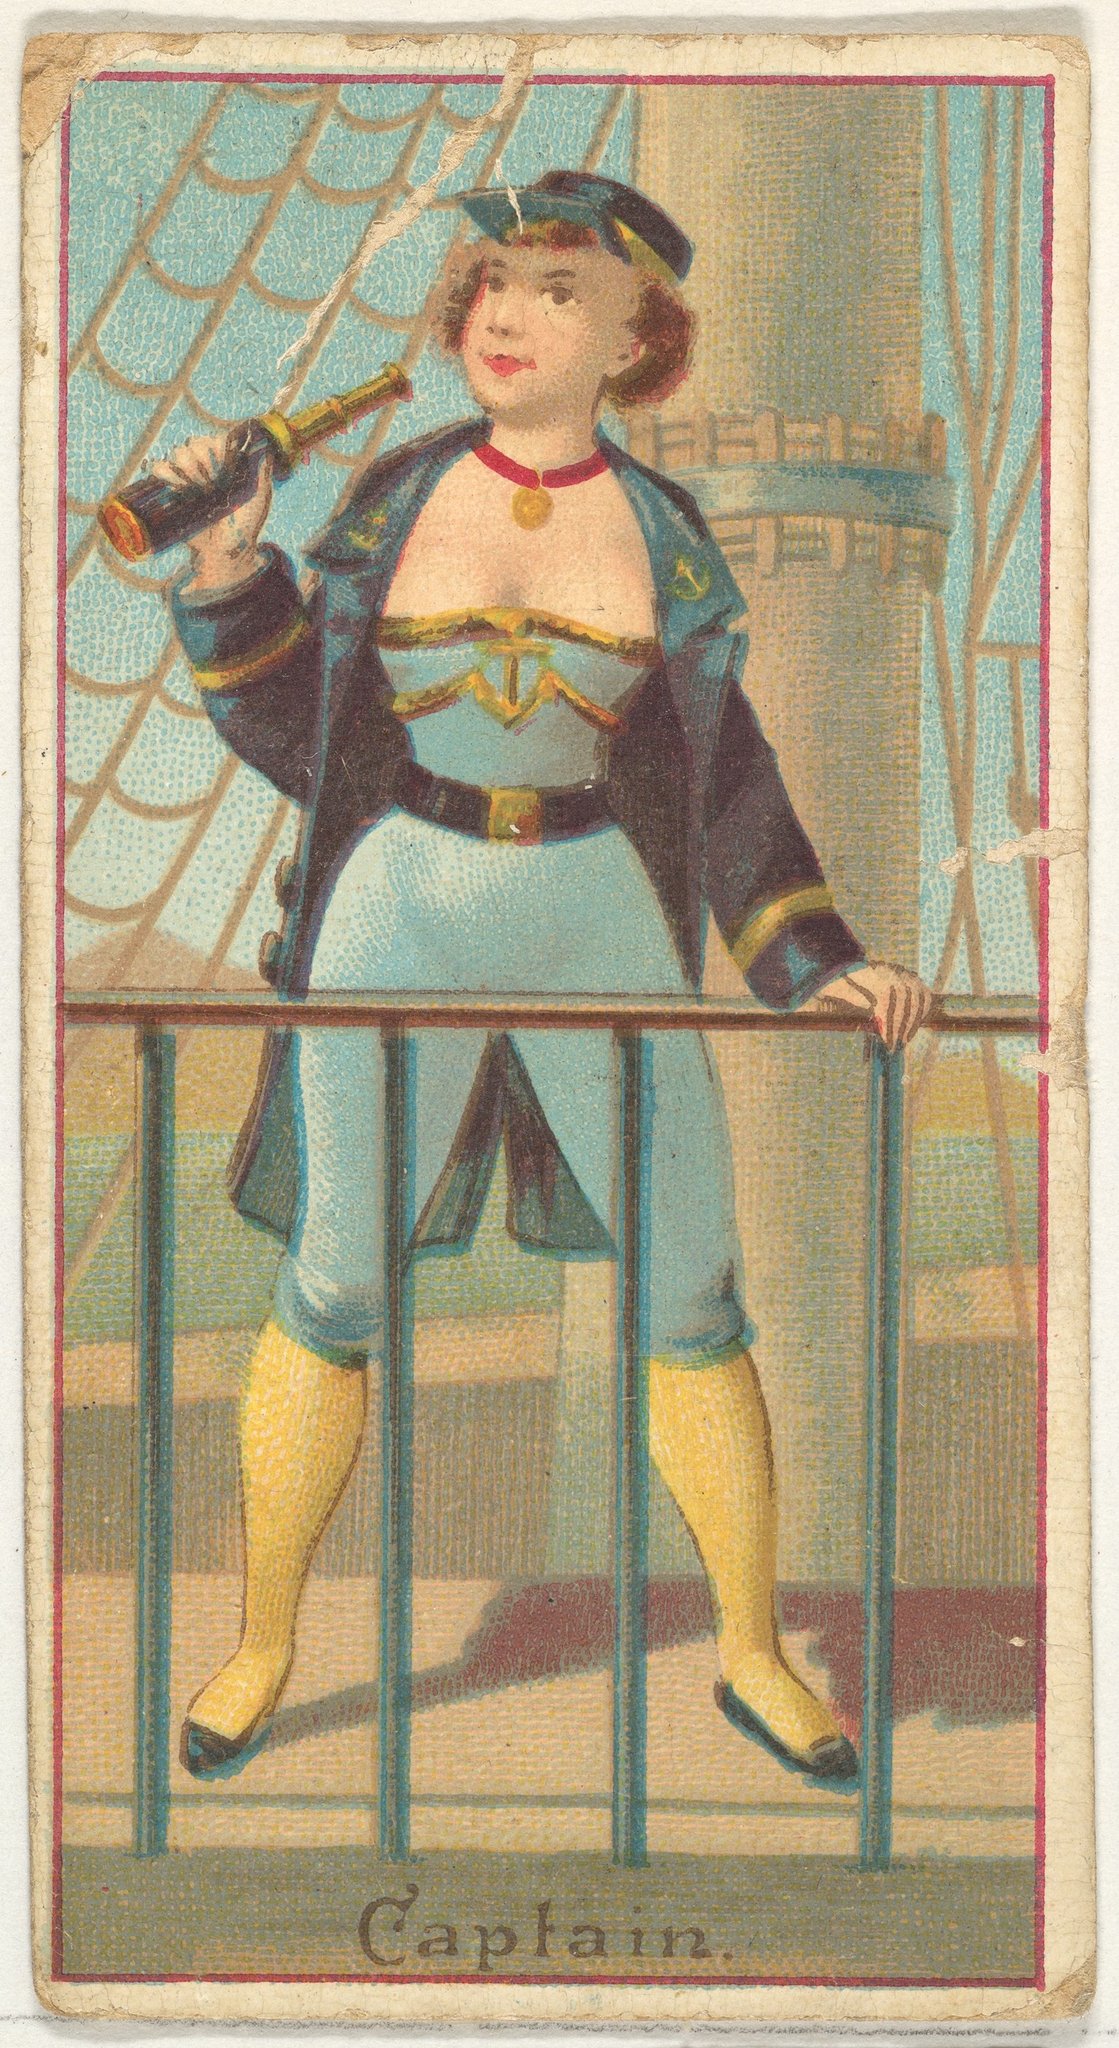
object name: print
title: Captain, from the Occupations of Women series (N502) for Frishmuth's Tobacco Company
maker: frishmuth's tobacco company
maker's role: publisher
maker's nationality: american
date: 1889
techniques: color lithograph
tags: women